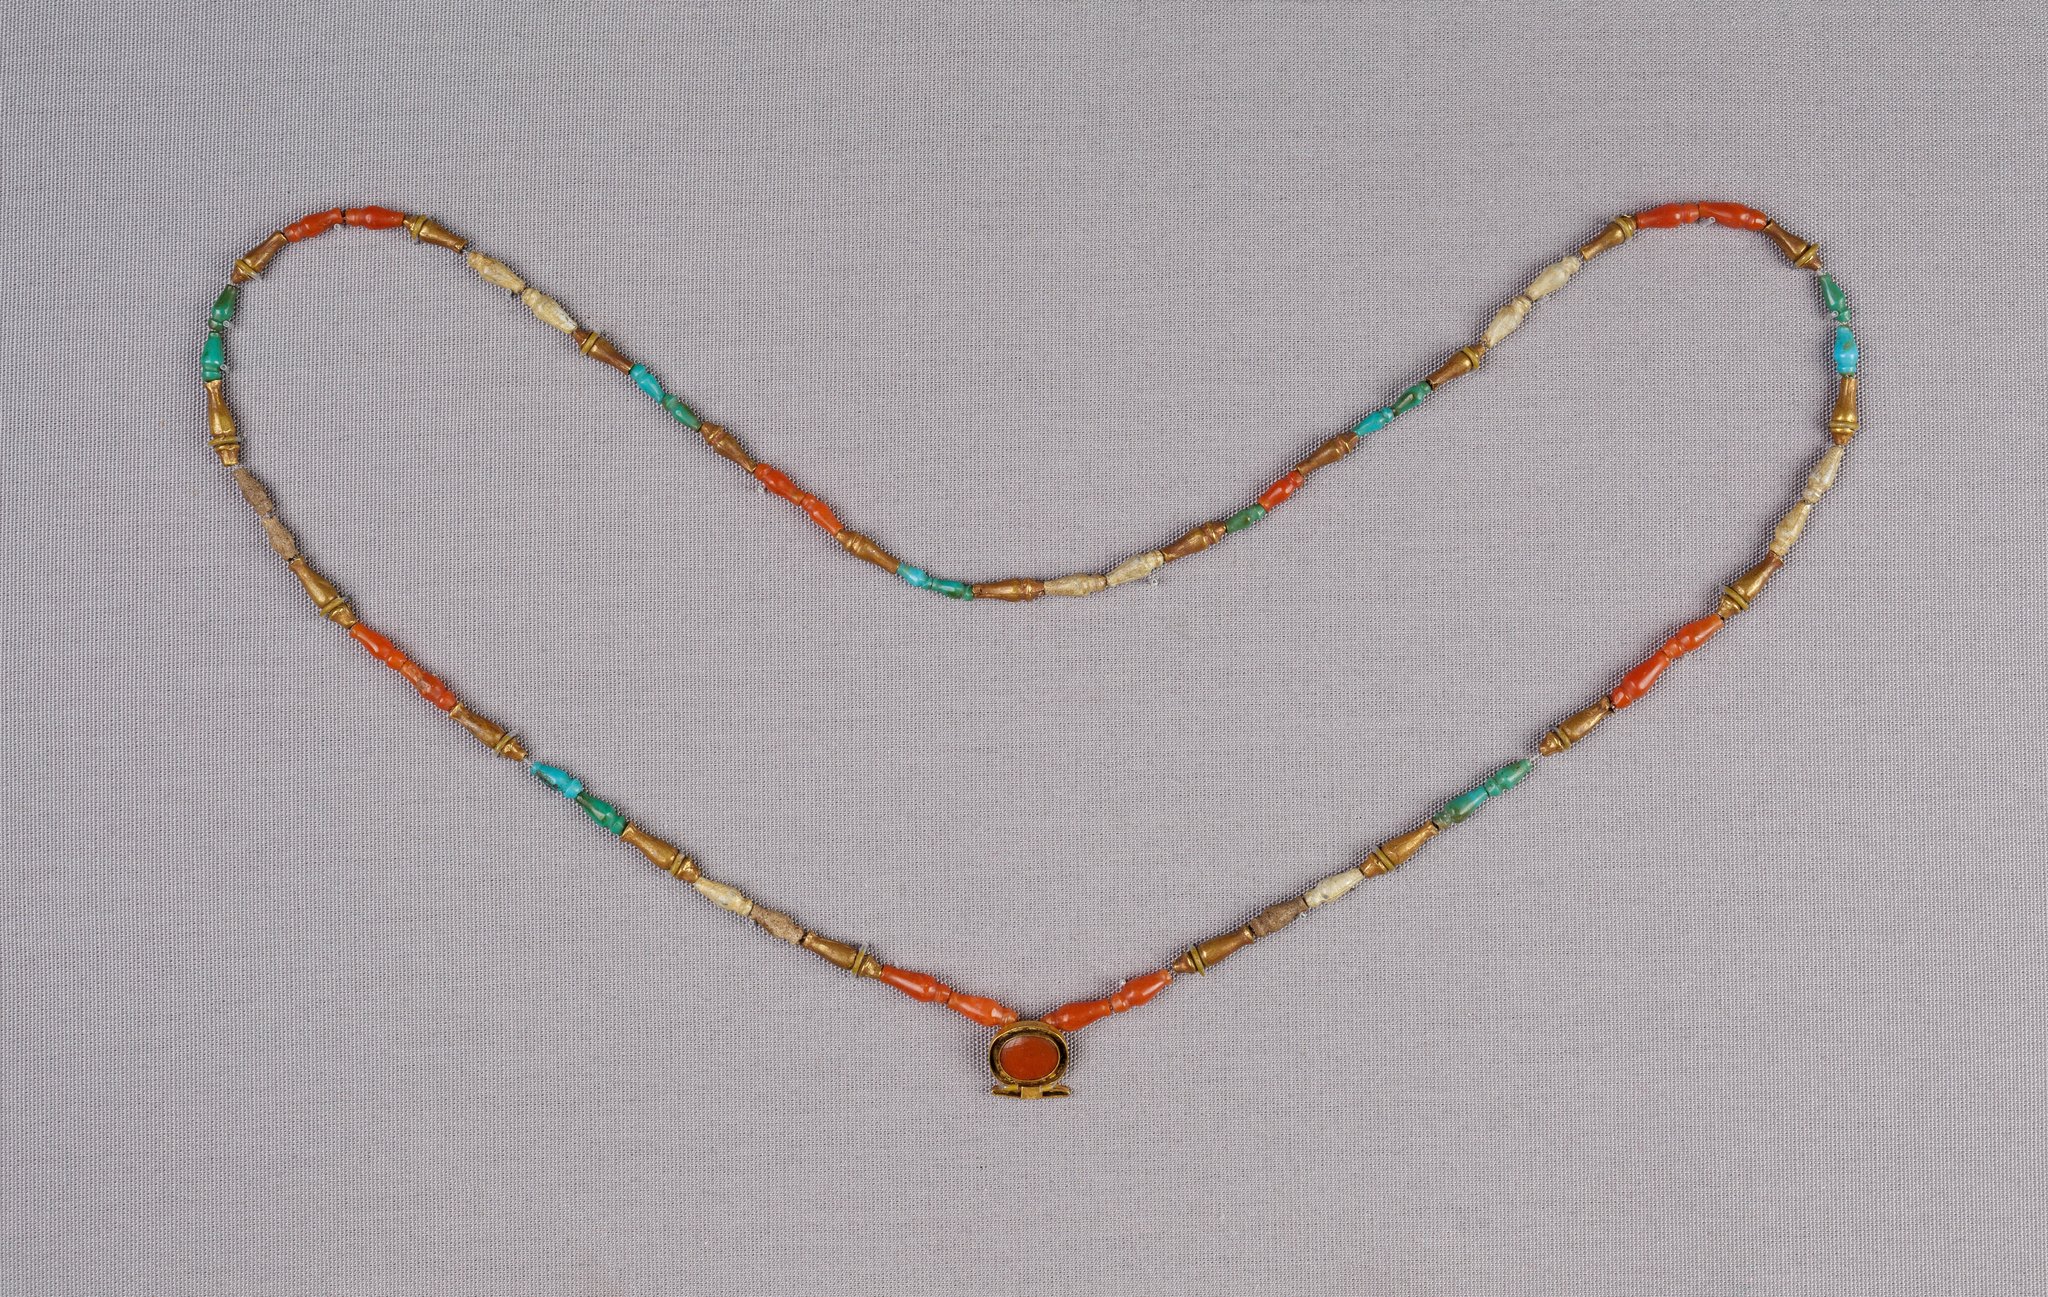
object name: necklace, shen amulet, senebtisi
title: Necklace with Shen-Amulet of Senebtisi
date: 1859-1770 BCE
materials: gemstone, faience, gold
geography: egypt